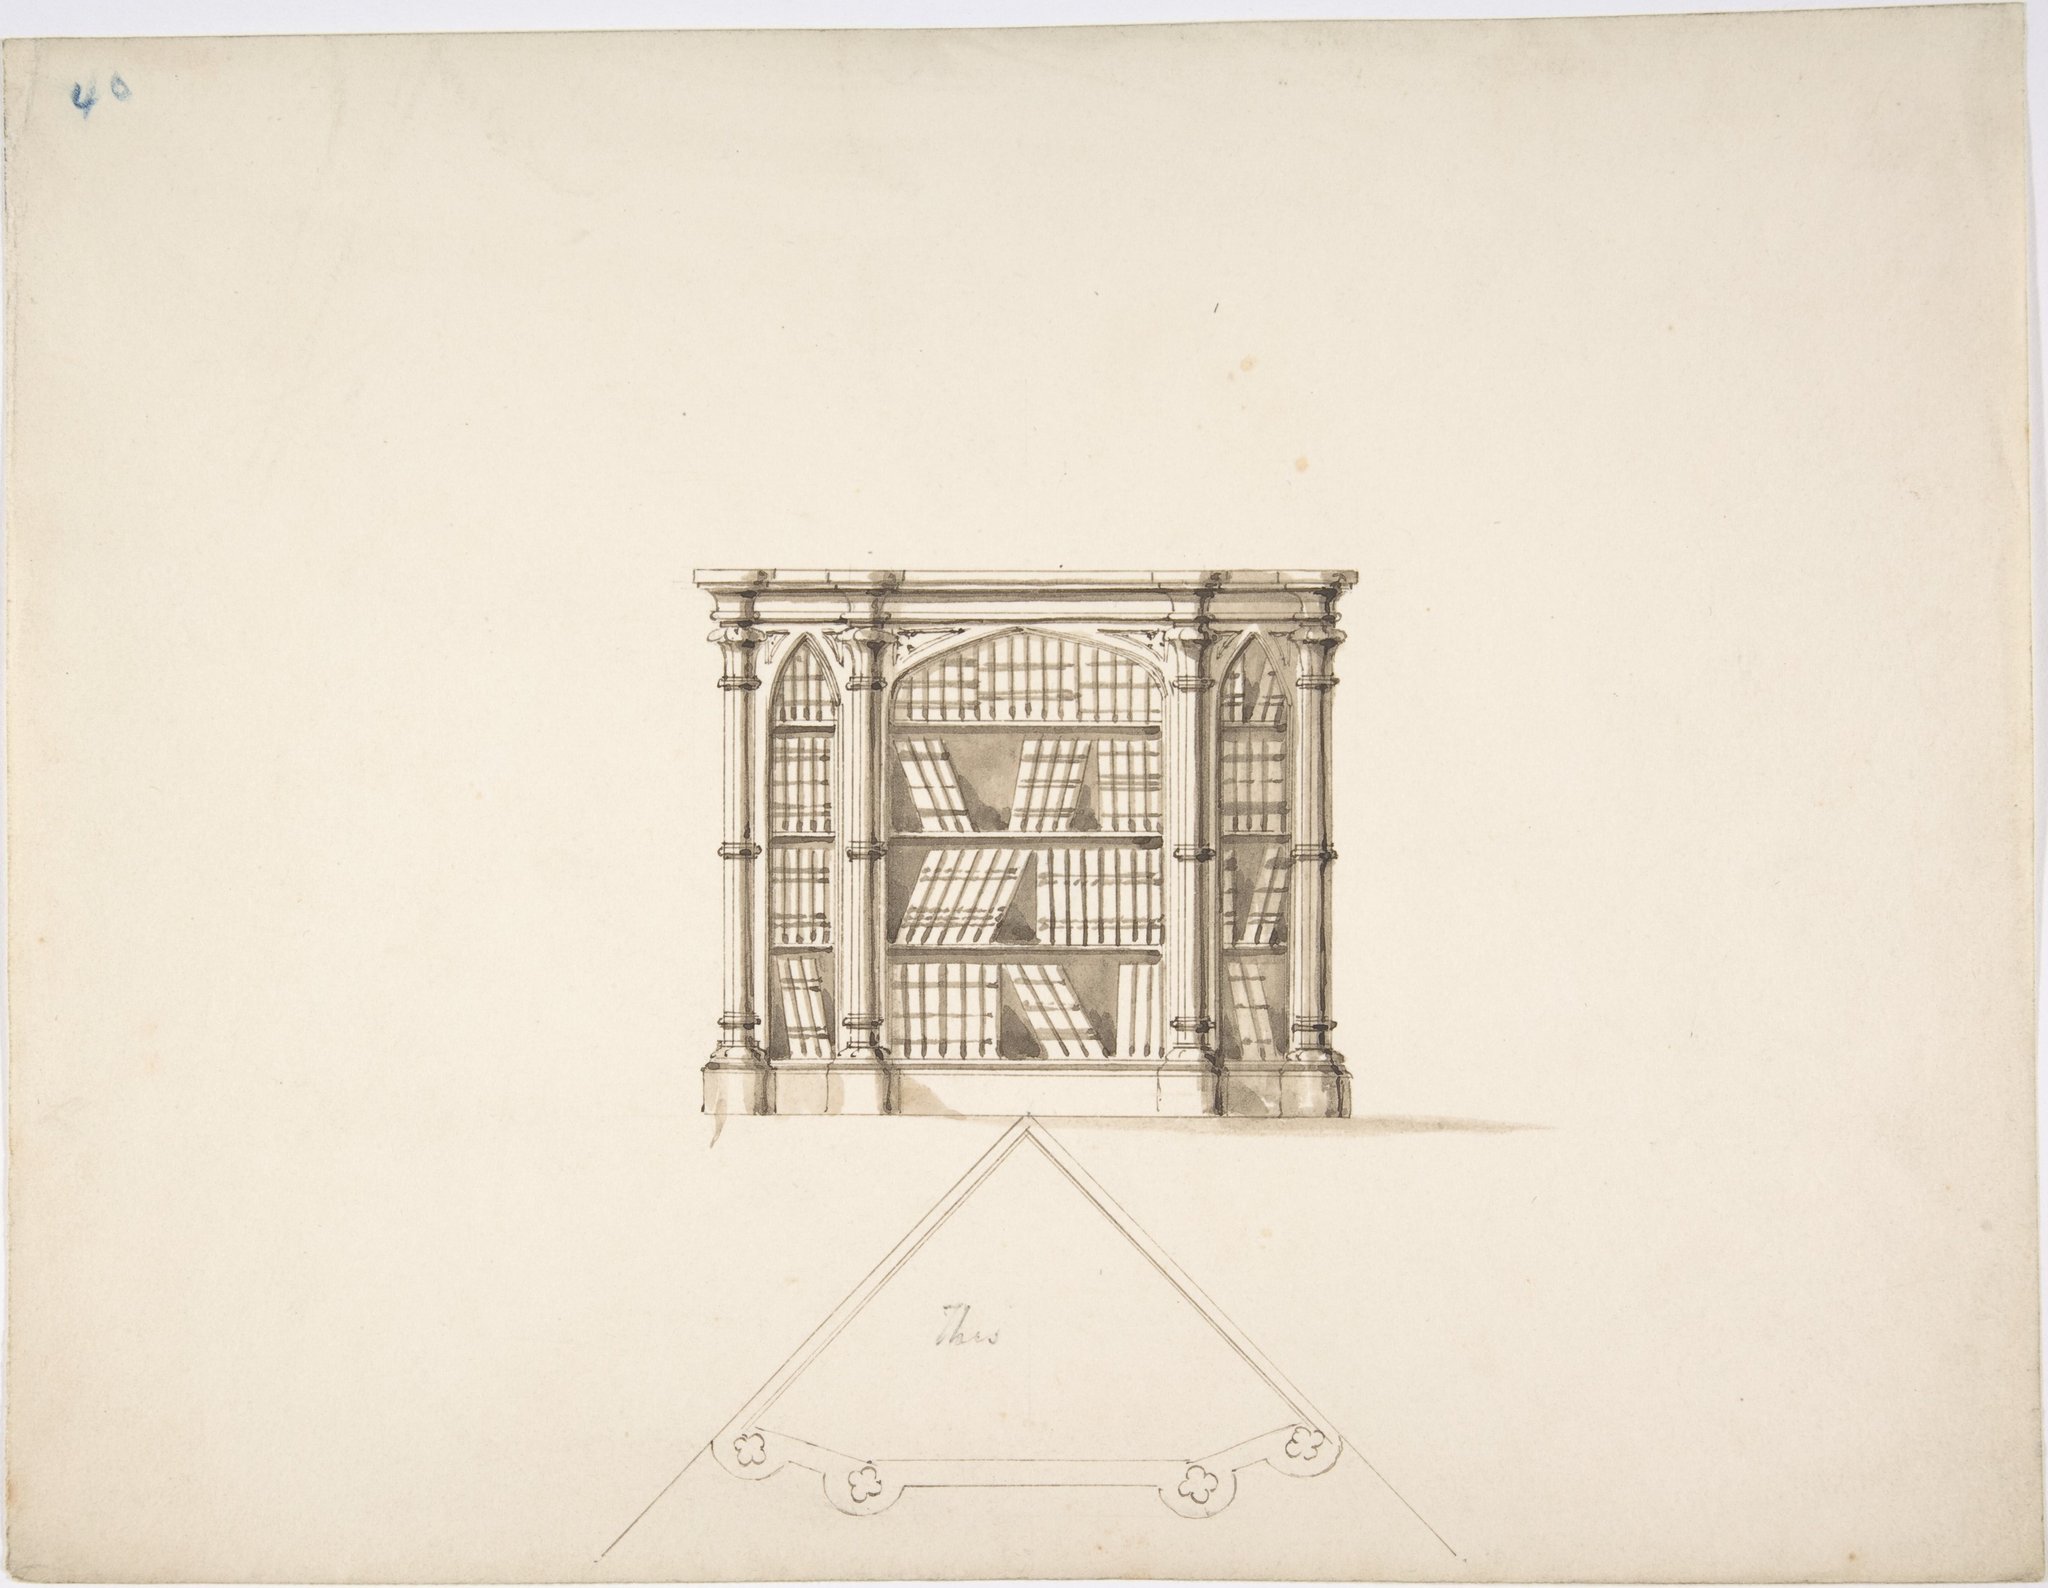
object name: drawing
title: Design for a Gothic Style Corner Book Cabinet: Elevation and Plan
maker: anonymous, british, 19th century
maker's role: artist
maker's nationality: british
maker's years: 1800-1900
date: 1801-1833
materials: ink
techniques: brush, pen, wash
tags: cabinets